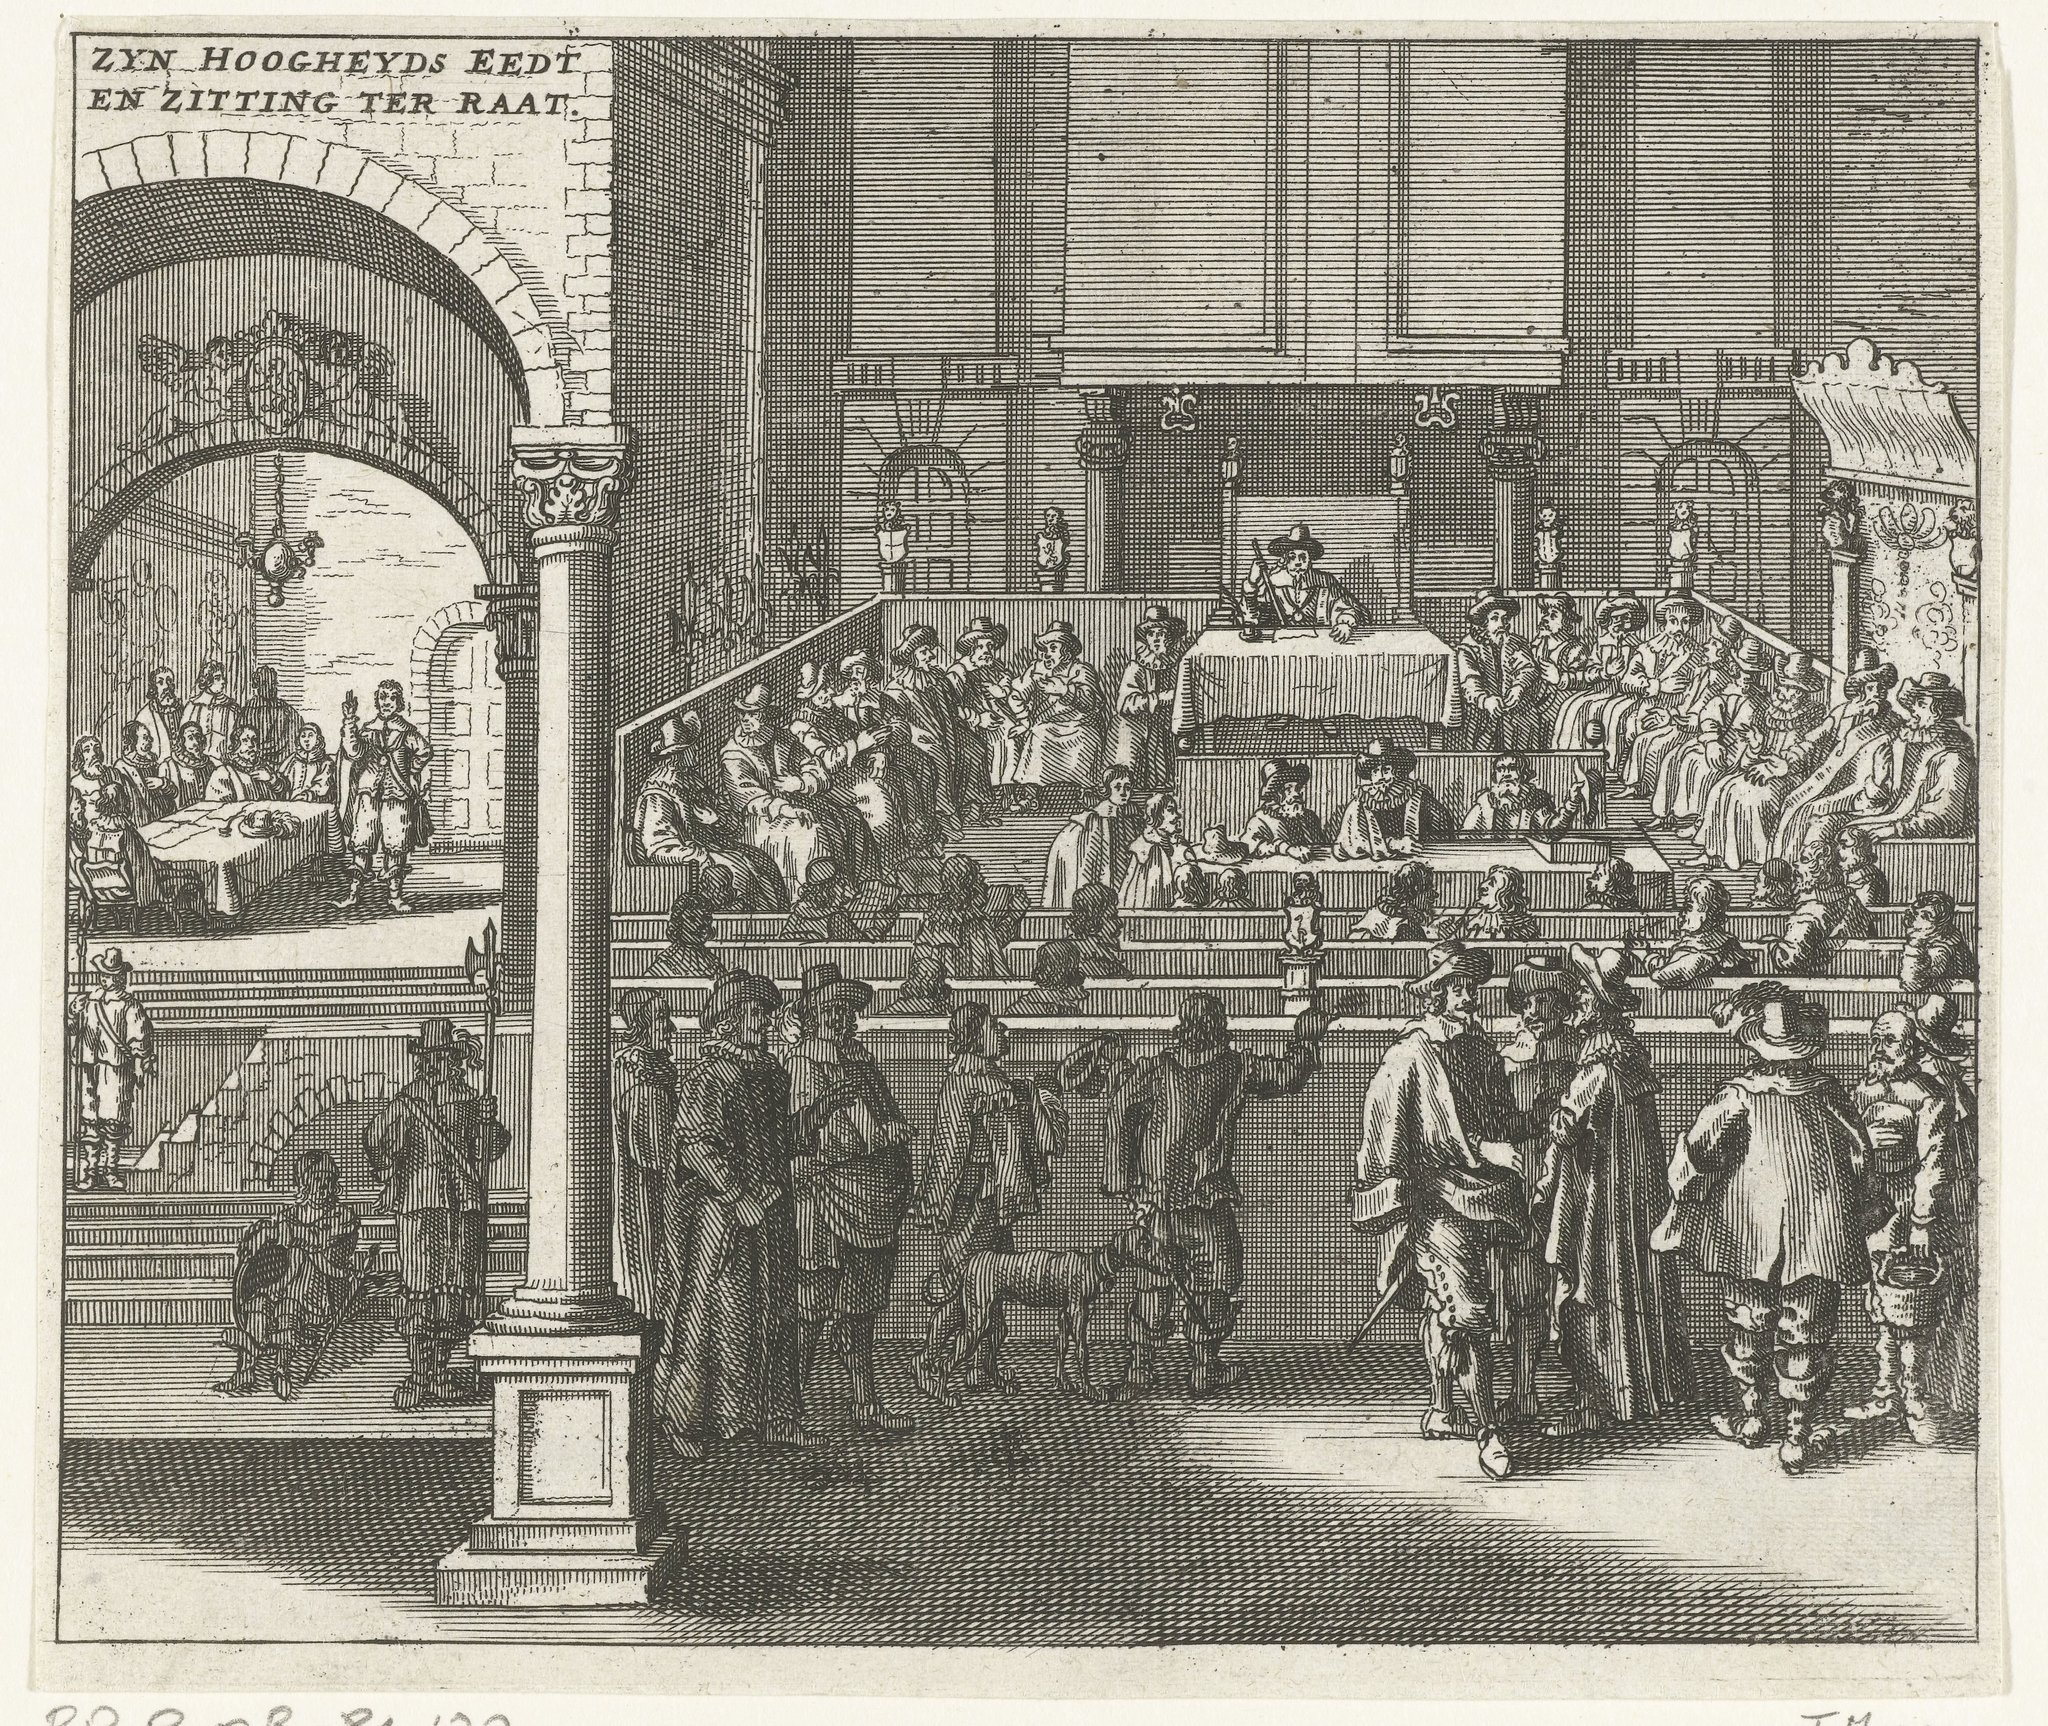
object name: print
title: Frederik Hendrik legt de eed af als stadhouder en neemt zitting in de Staten van Holland, 1625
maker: Anonymous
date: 1651-1699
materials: paper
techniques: engraving, etching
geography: northern netherlands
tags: frederick henry (prince of orange), new ruler taking the oath, popular representation ~ government, the hague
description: Frederik Hendrik legt de eed af als nieuwe stadhouder en neemt zitting in de Staten van Holland, september 1625. Links legt Frederik Hendrik staande de eed af. Rechts de Staten van Holland bijeen in zitting in aanwezigheid van Frederik Hendrik.